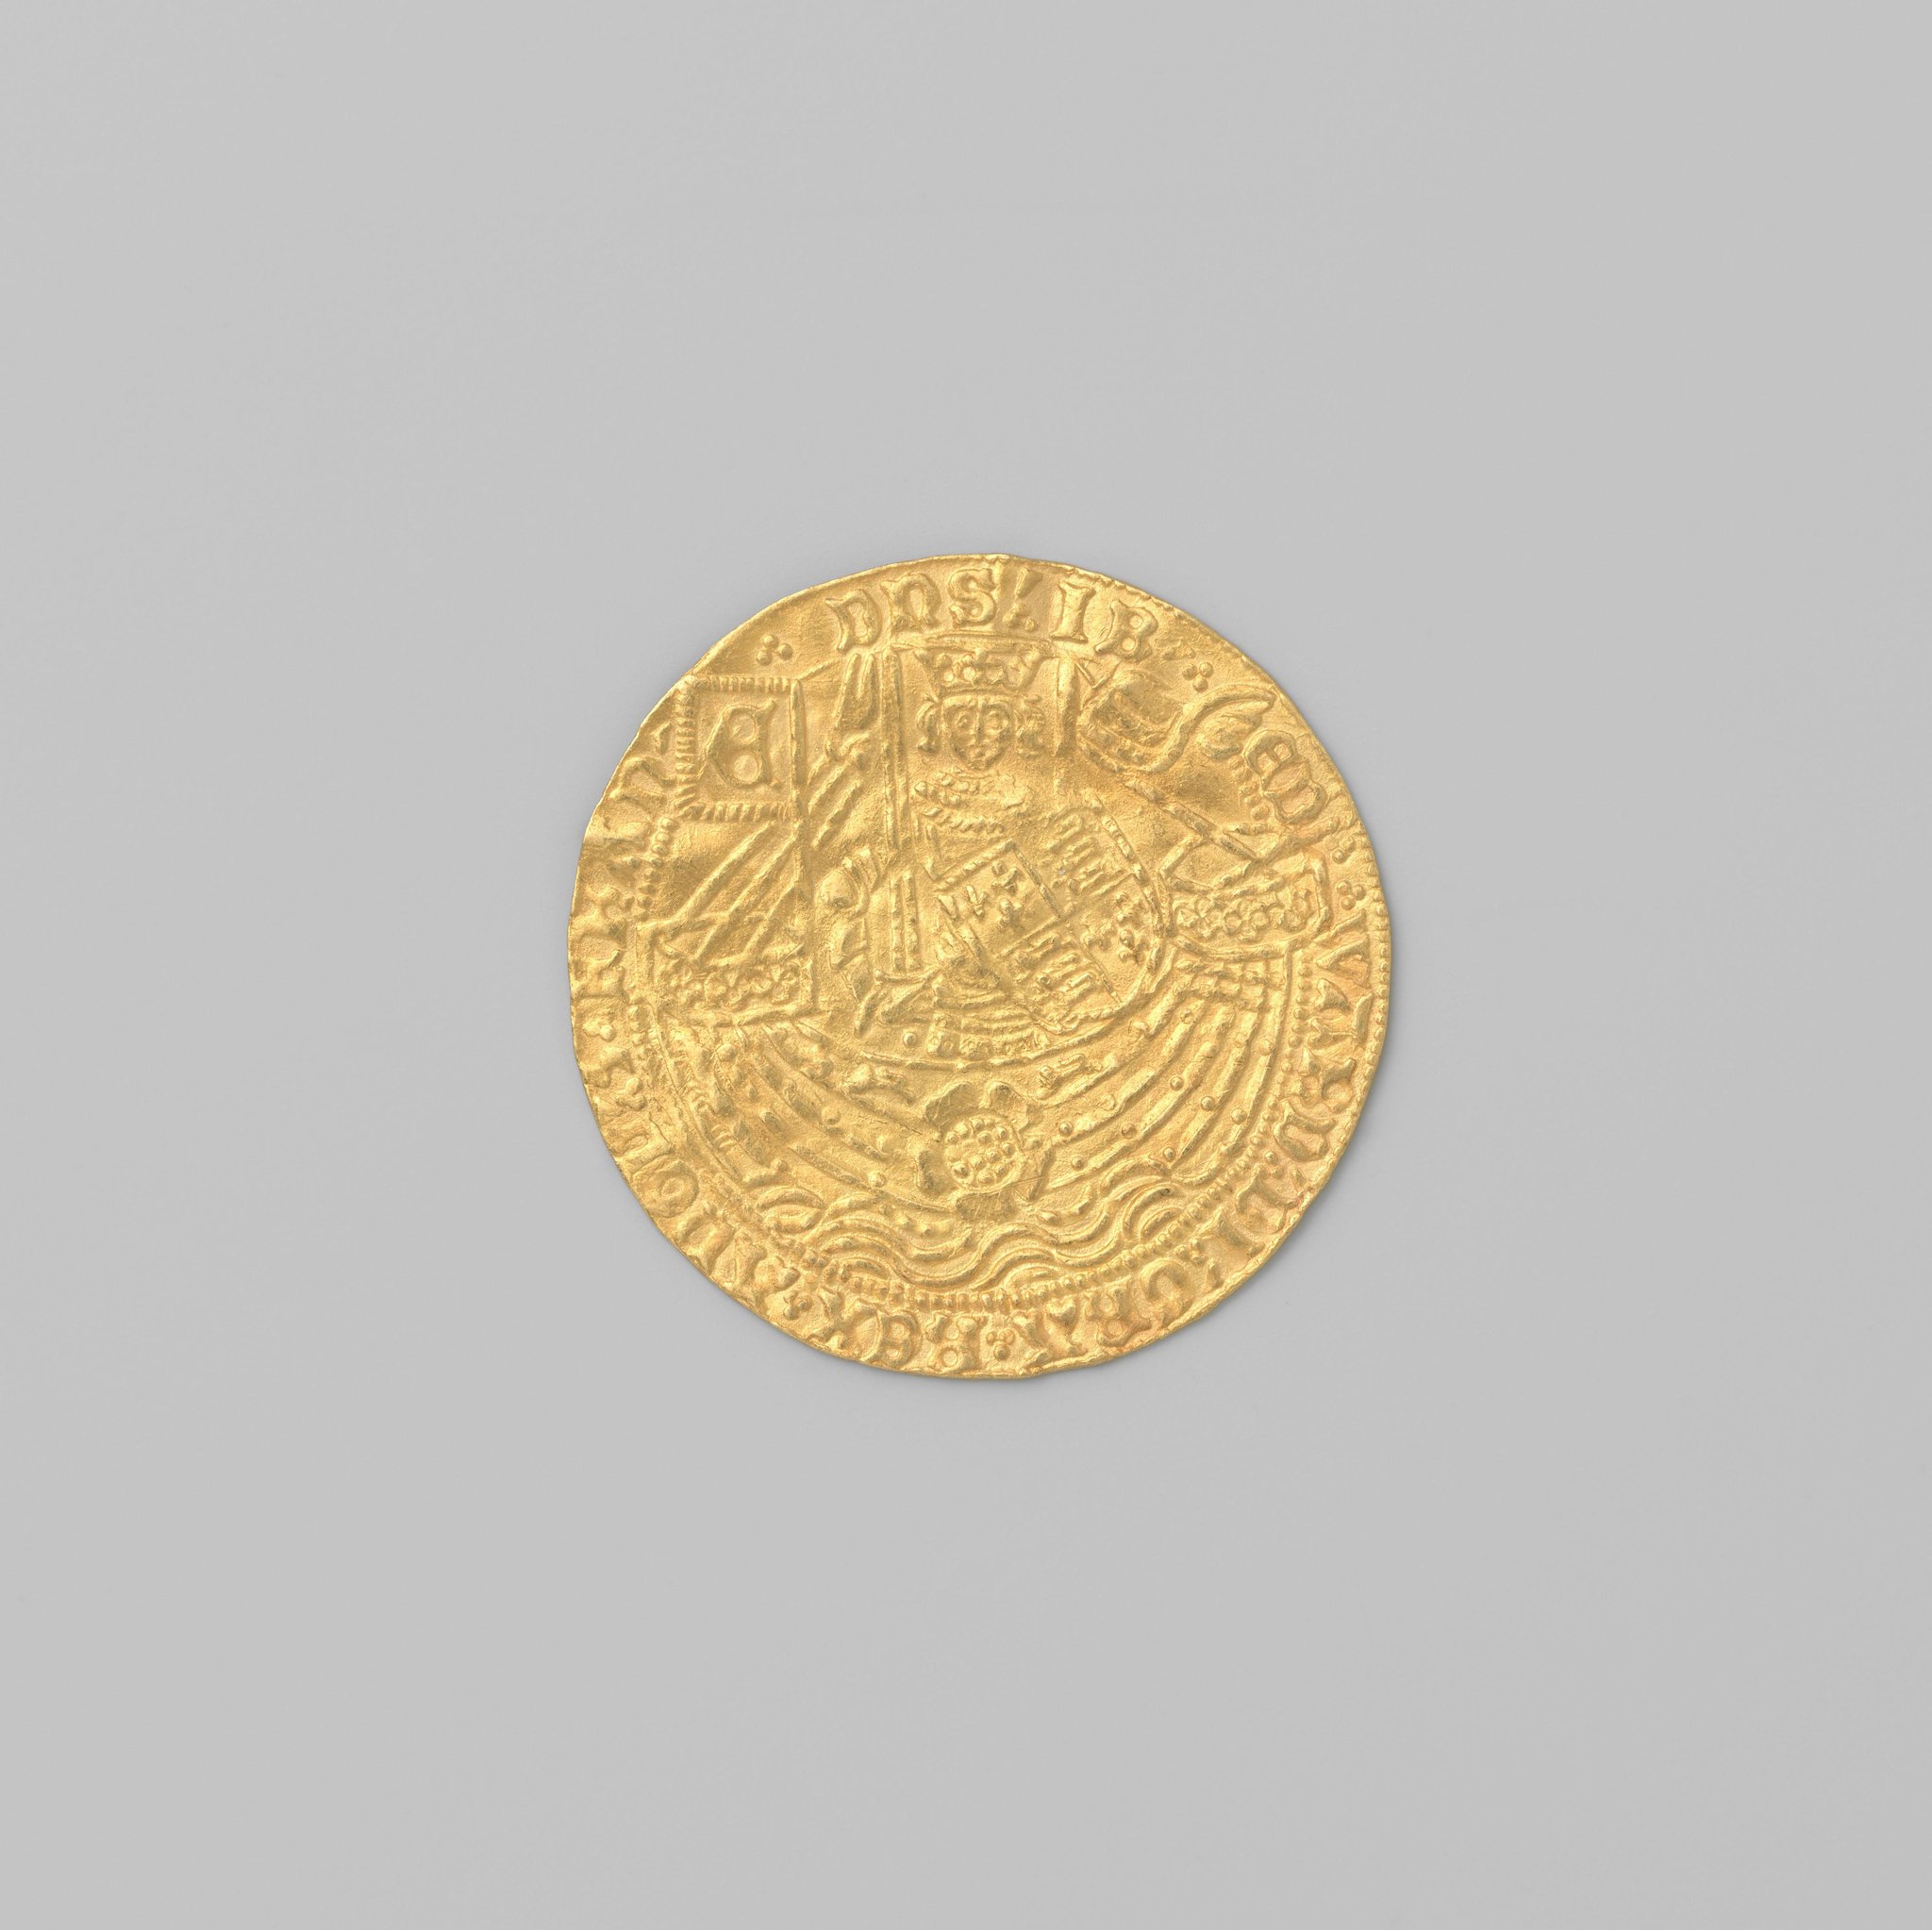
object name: rozenobel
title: Gouden rozenobel Gorkum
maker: Anonymous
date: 1590-1600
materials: gold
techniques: striking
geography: europe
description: Gouden handelsmunt afkomstig uit Nederlandse schatvondst (Huizinge). Zeer scherp exemplaar.